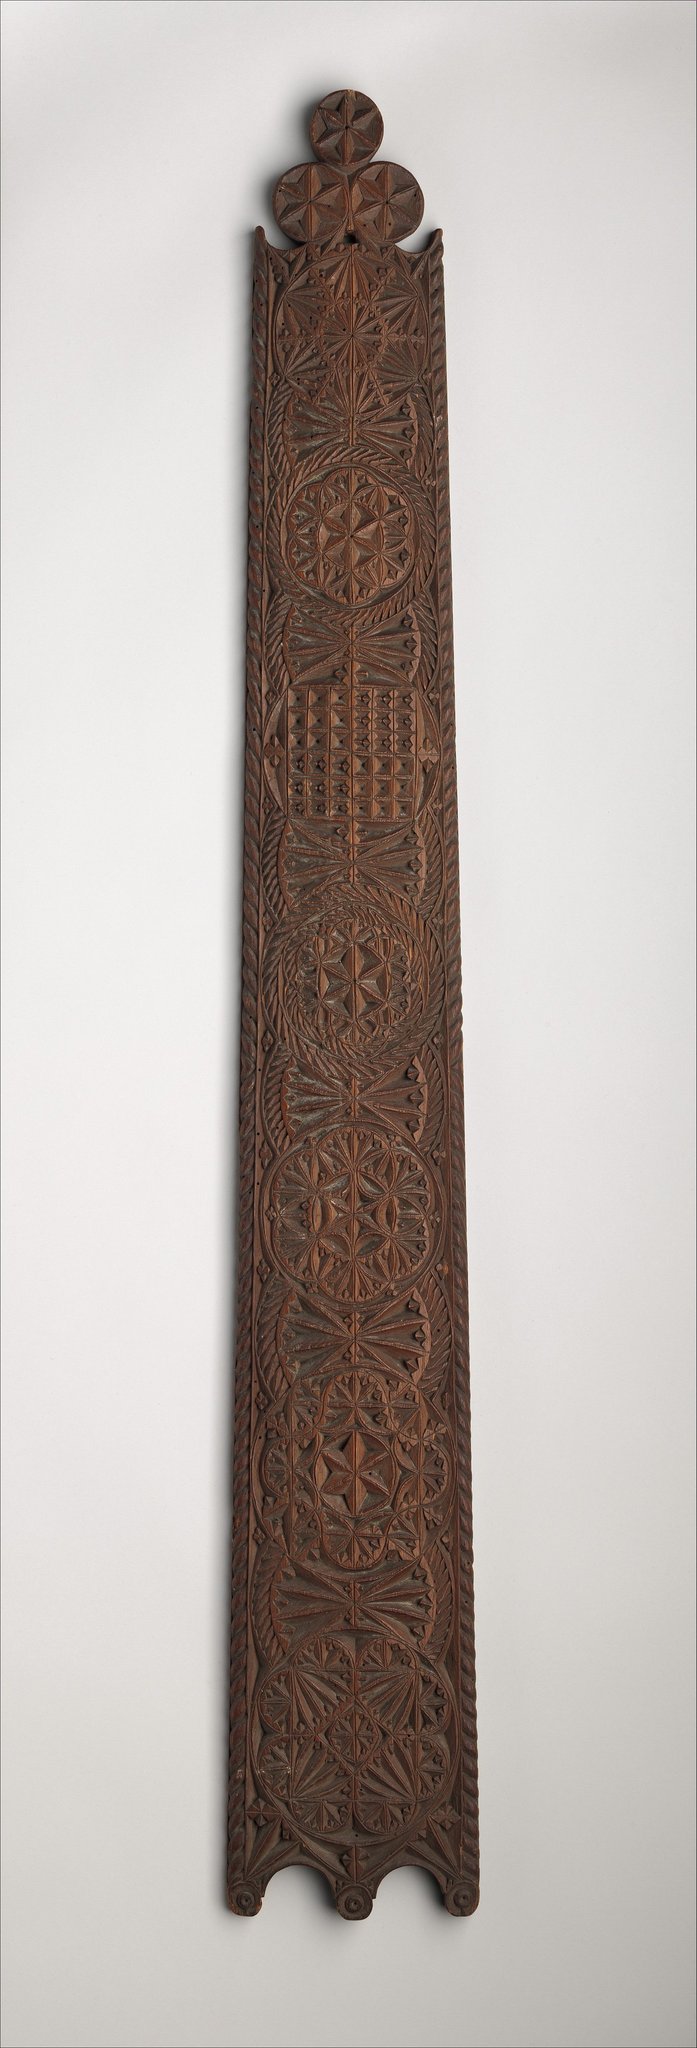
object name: mangle board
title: Mangle-board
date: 1701-1800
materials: wood